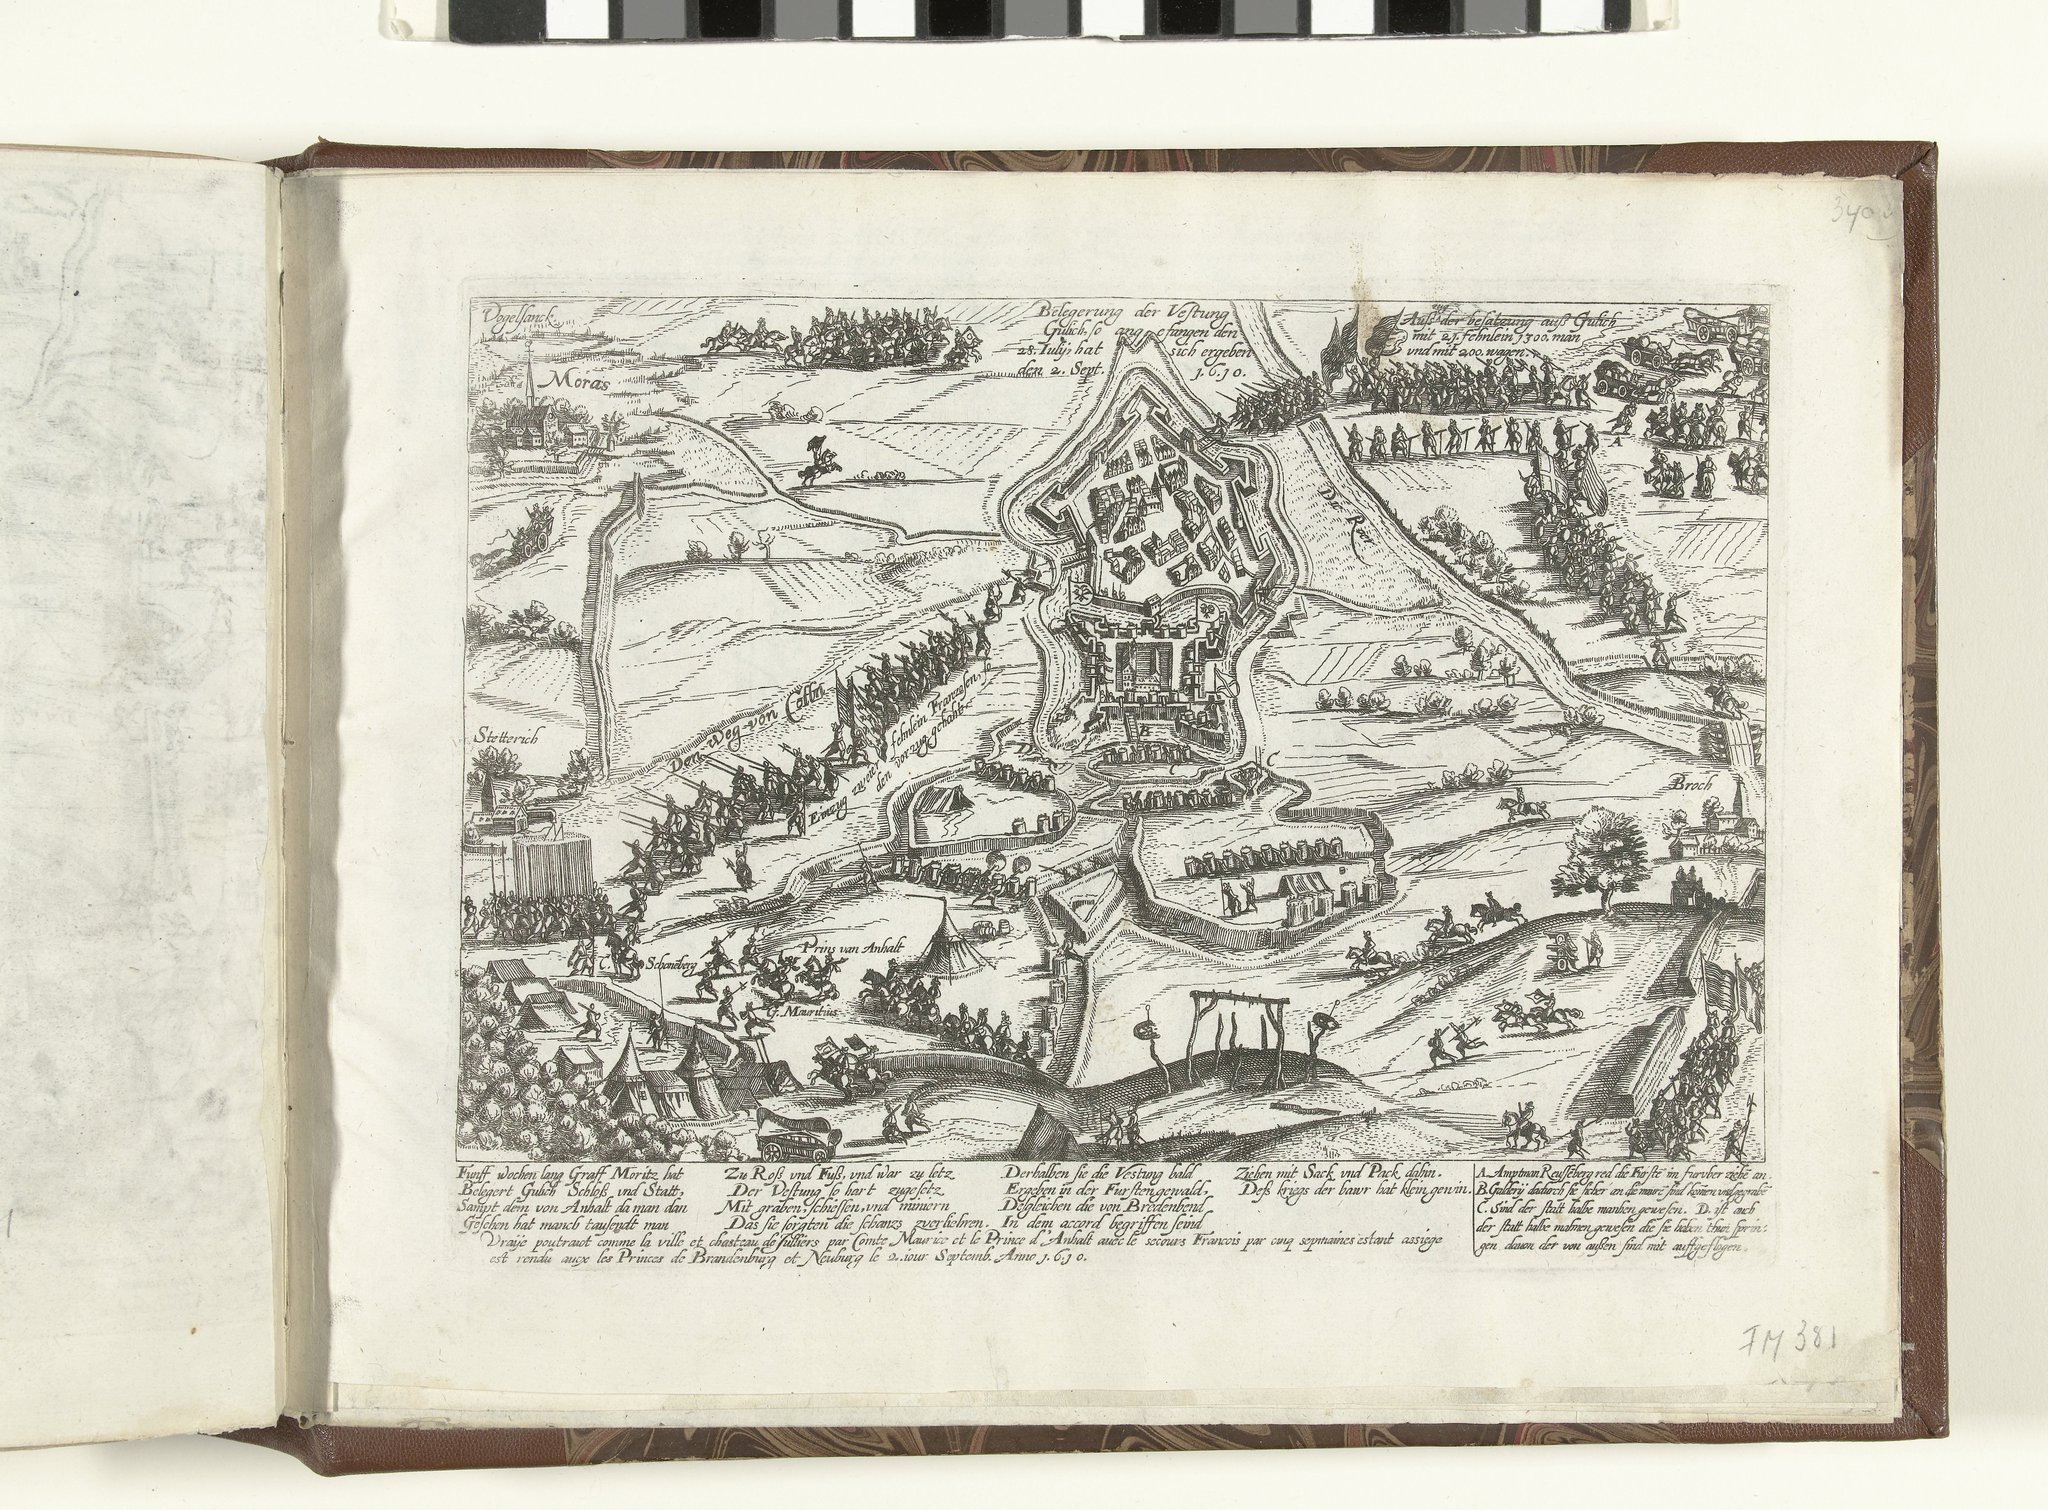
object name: print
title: Belegerung der Vestung Gulich, so angefangen den 28 Julij, hat sich ergeben den 2. Sept. 1610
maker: frans hogenberg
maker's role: print maker, publisher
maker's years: 1538-1590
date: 1610-1612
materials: paper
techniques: etching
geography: cologne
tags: maurice (prince of orange), capture of city (after the siege)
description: Inname van Gulik door prins Maurits en de vorst van Anhalt, 2 september 1610. Linksonder trekken Franse troepen de stad in, bovenaan verlaten de verdedigers Gulik. Met onderschrift van 14 regels in het Duits en 2 regels in het Frans en met legenda A-D. Ongenummerd.